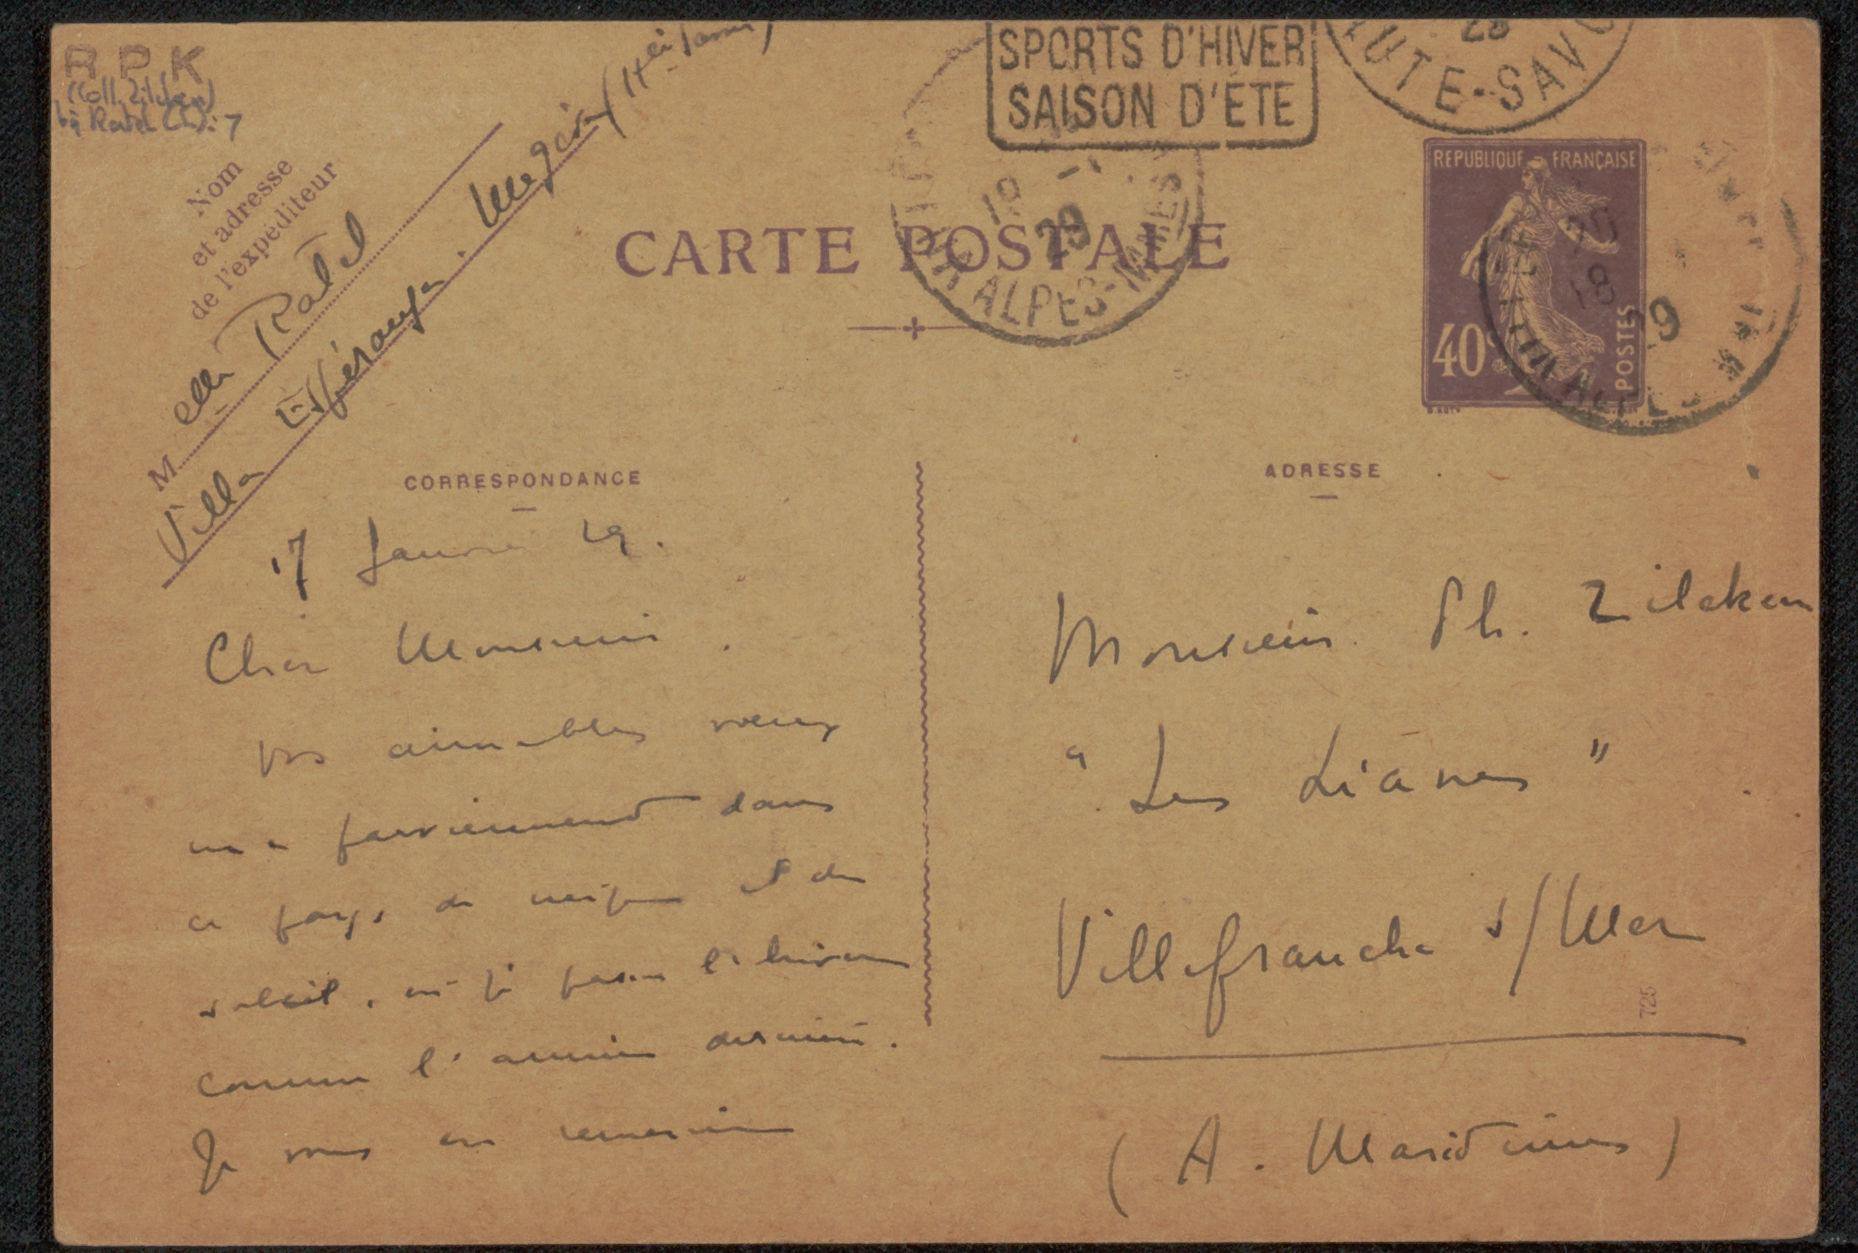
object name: postcard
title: Briefkaart aan Philip Zilcken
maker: simonne ratel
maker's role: schrijver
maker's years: 1900-1948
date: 1929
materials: cardboard, ink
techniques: pen, writing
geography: megève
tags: the hague, painter, draughtsman, philip zilcken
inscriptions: collector's mark: ‘RPK’